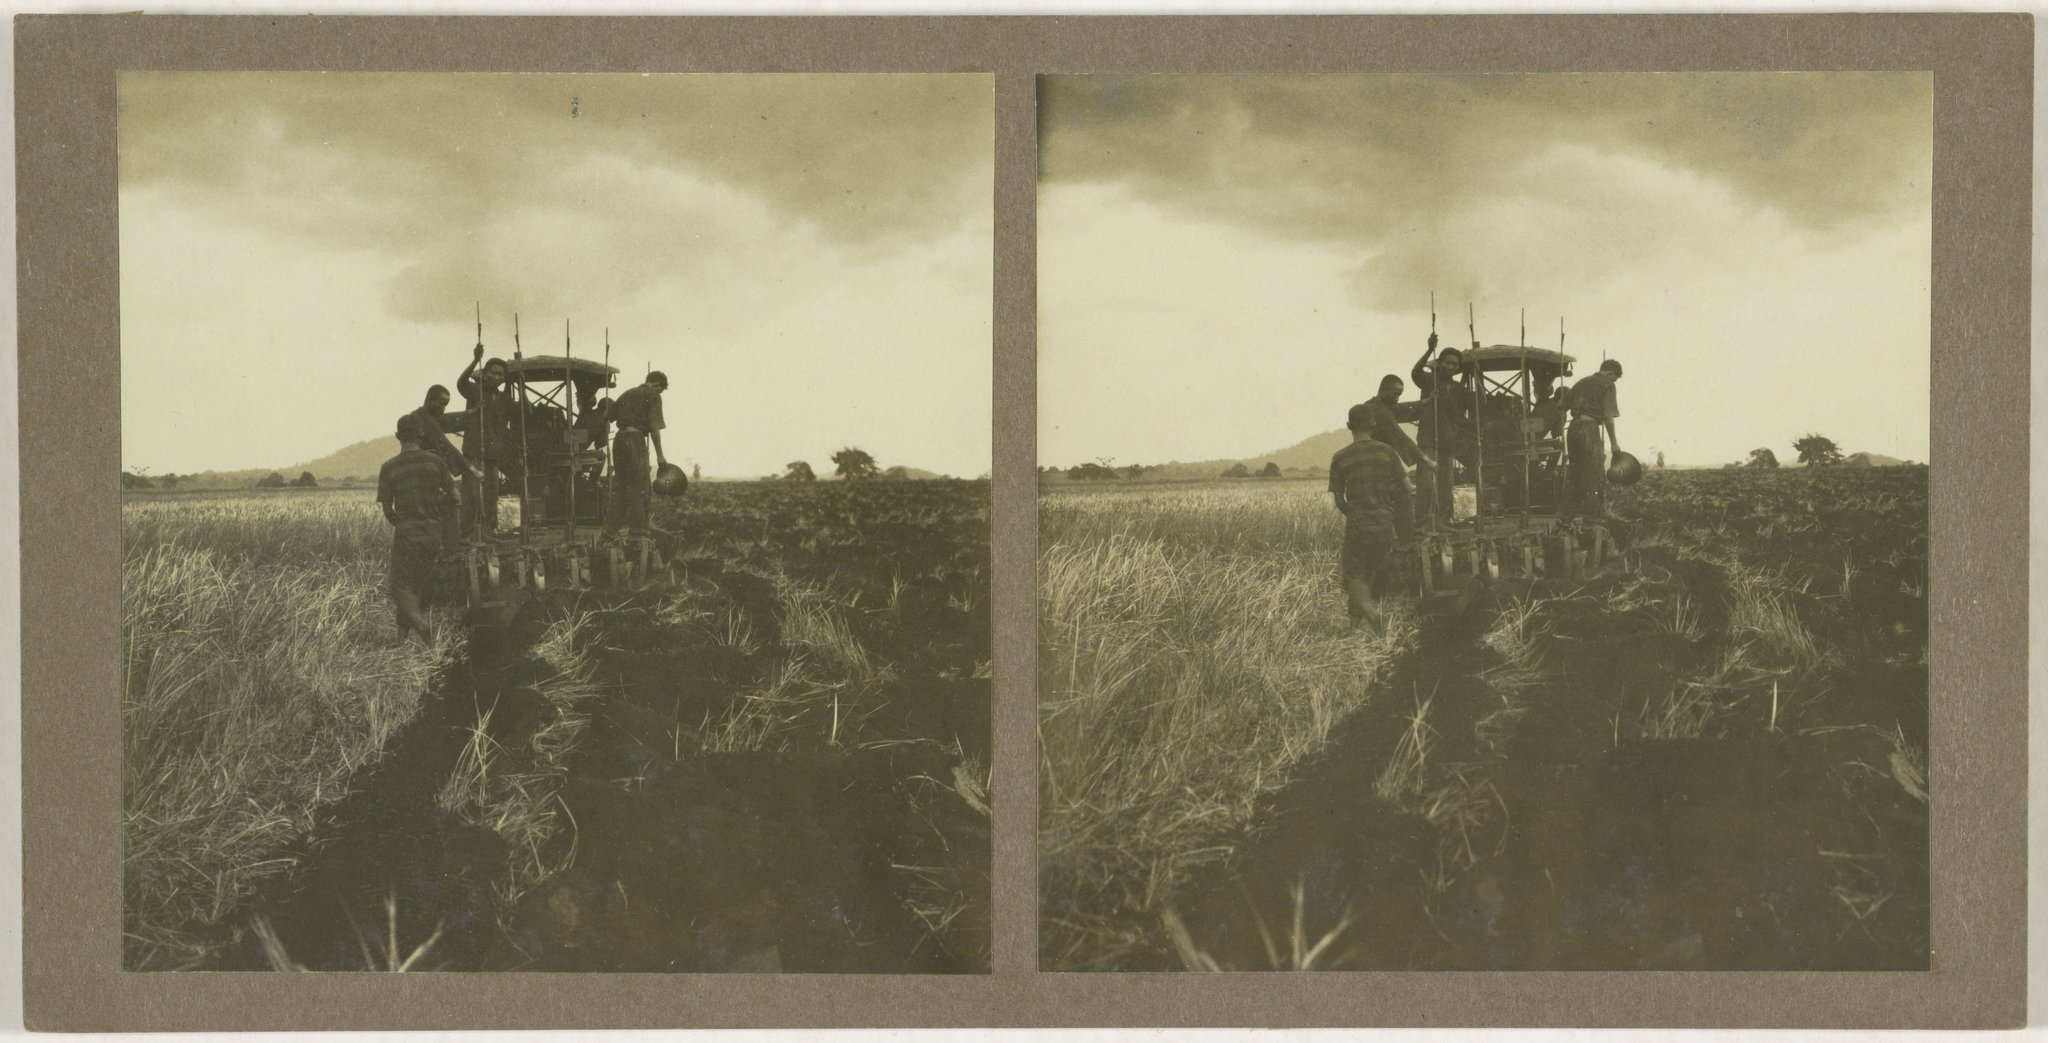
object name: stereograph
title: Ploegmachine met landarbeiders, mogelijk op Borneo, Indonesië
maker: Anonymous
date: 1900-1940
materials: paper, cardboard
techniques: gelatin silver print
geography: indonesia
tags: ploughing, indonesia